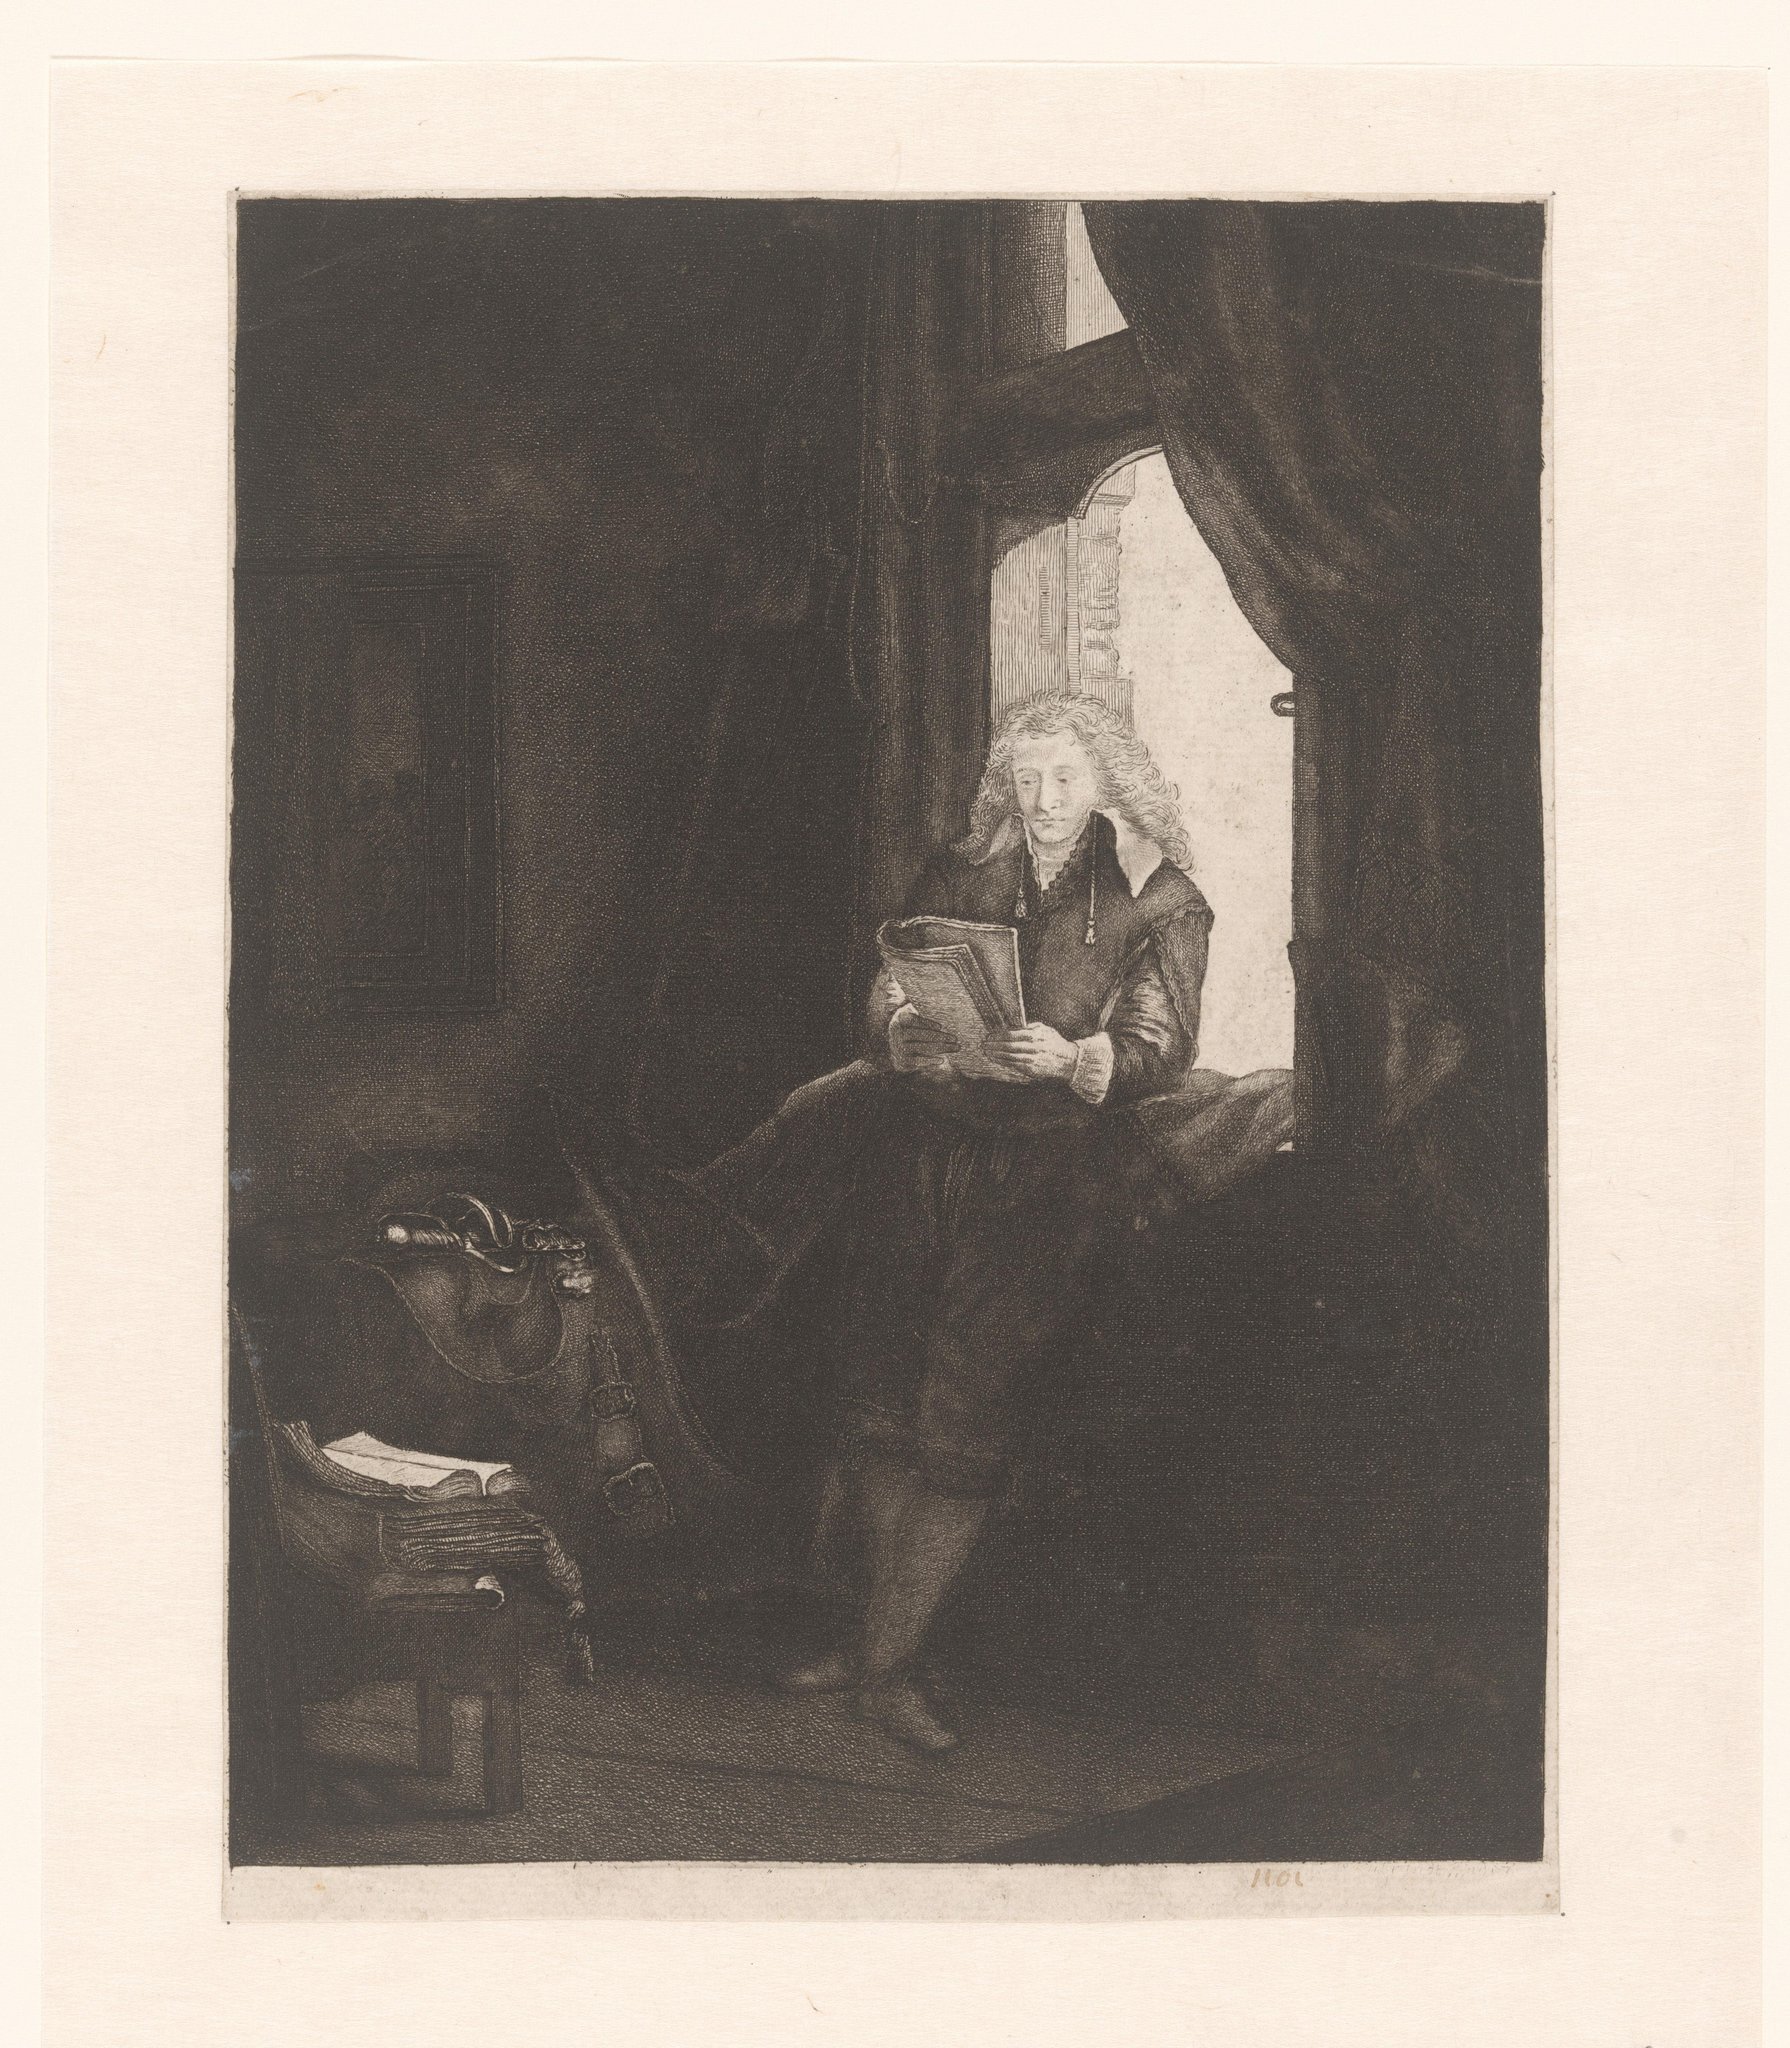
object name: print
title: Jan Six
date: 1733-1797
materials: paper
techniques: etching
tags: amsterdam, mayor, jan six (1618-1700), historical persons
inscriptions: collector's mark: Lugt 2228, collector's mark: Lugt 2760